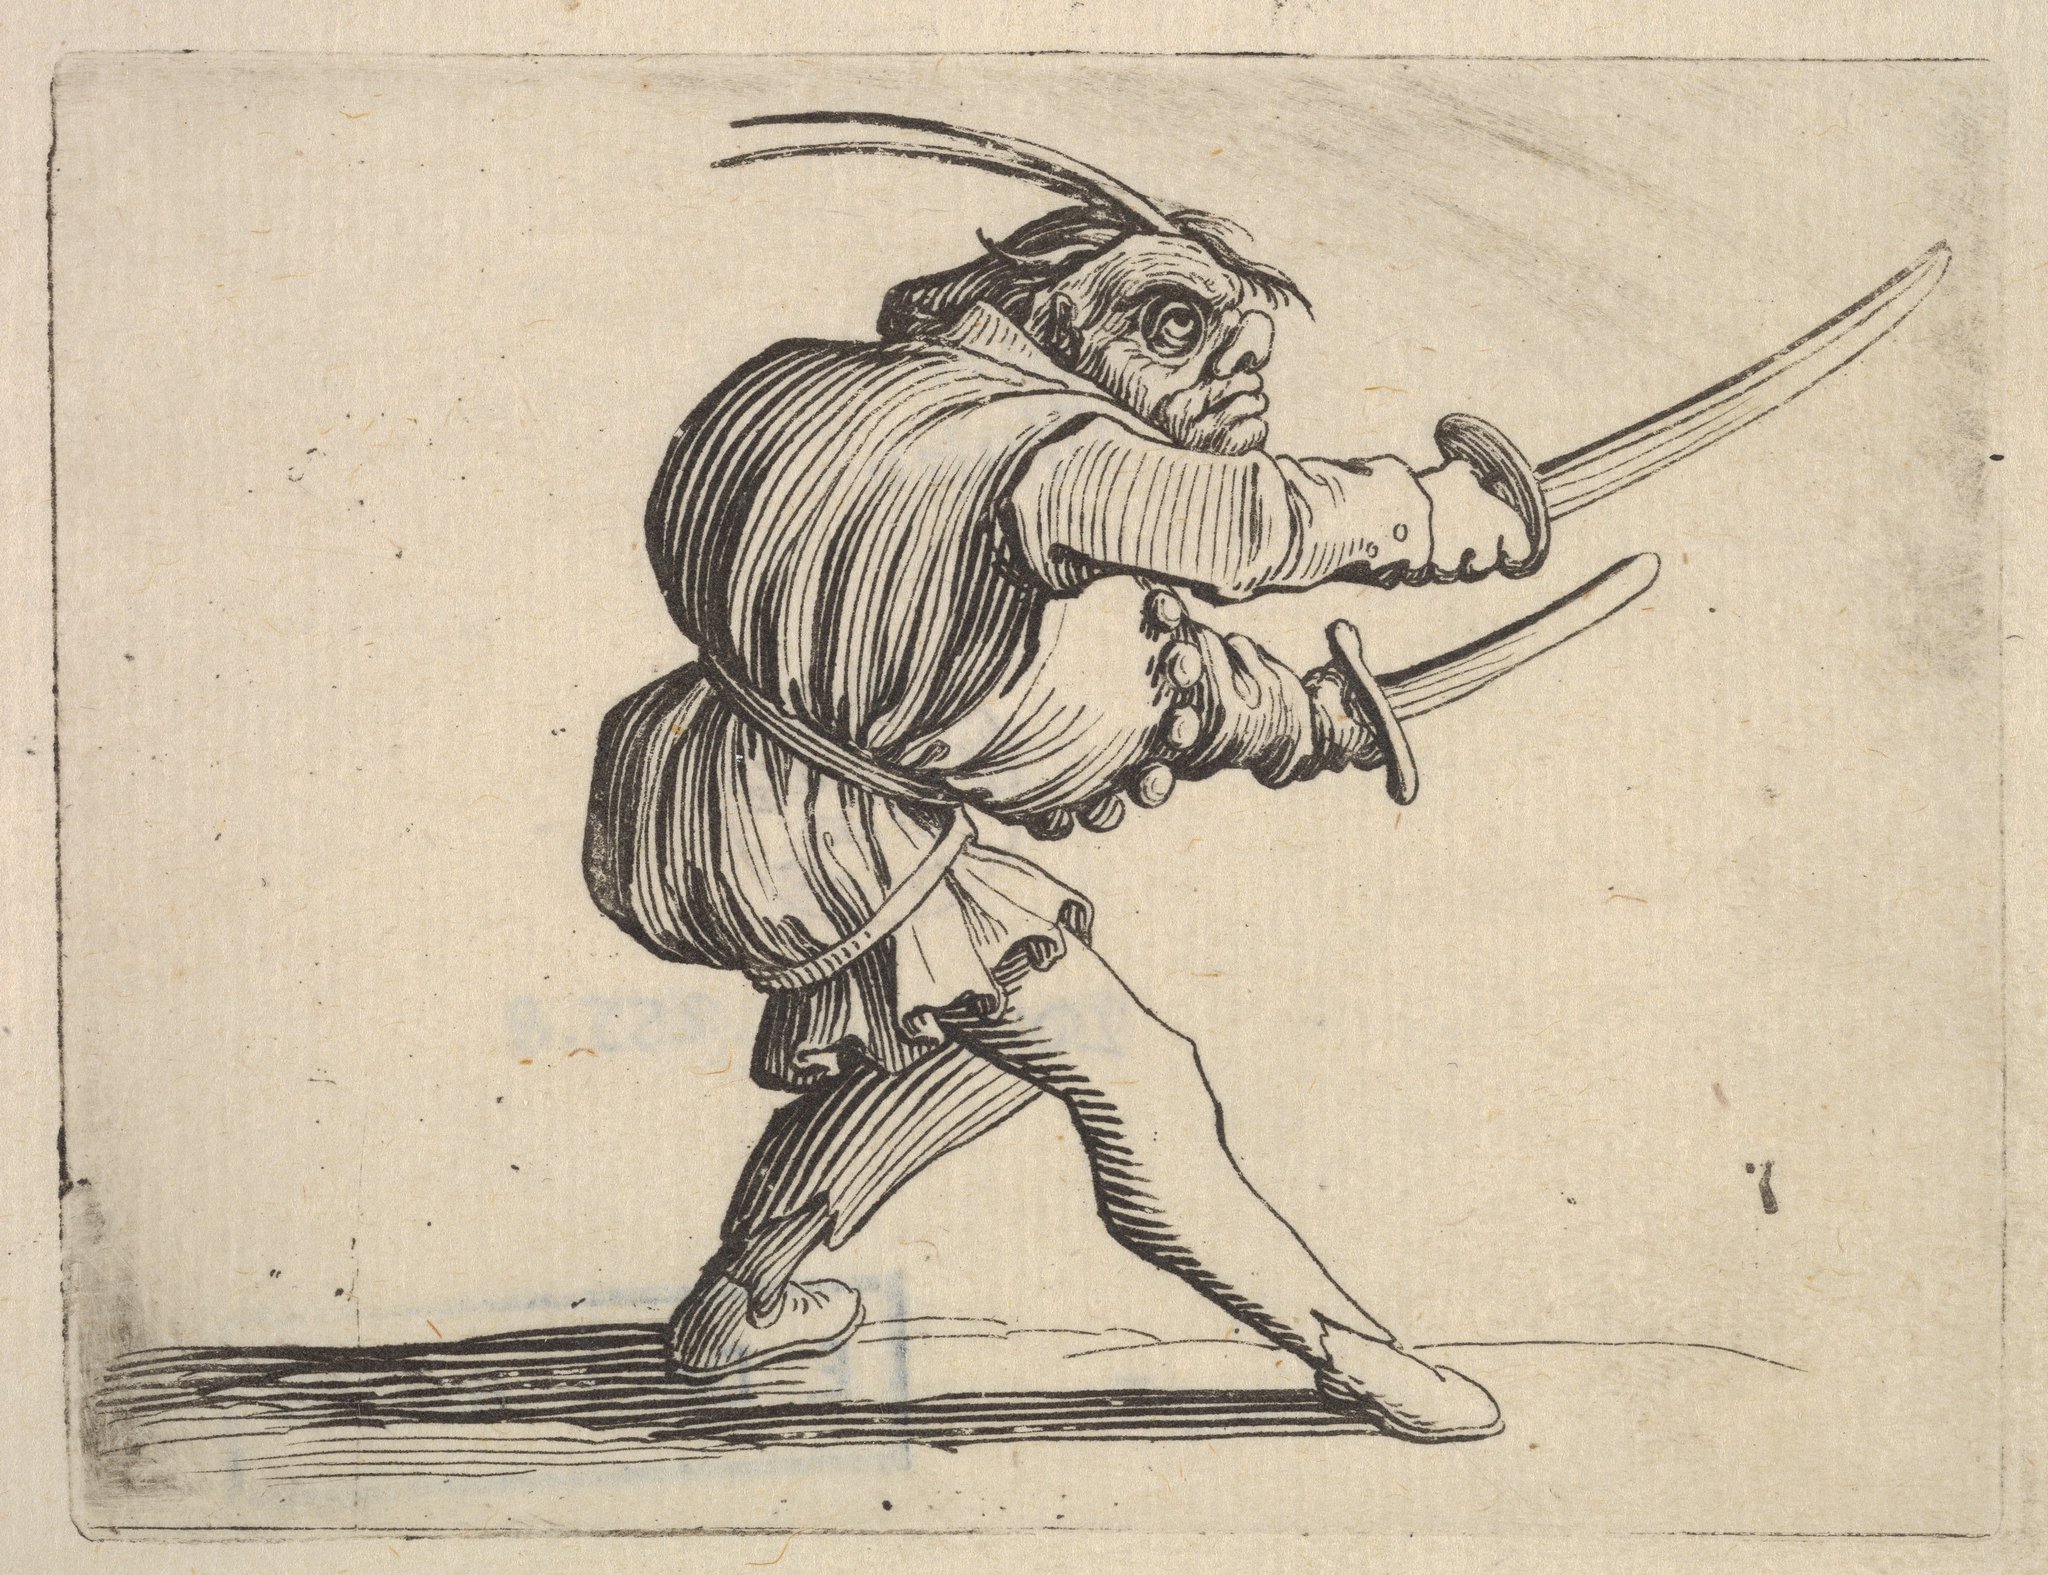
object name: print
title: Masked small figure with a sword in both hands, in profile view, striding to the right, from "Varie Figure Gobbi"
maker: jacques callot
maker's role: artist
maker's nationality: french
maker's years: 1592-1635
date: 1621-1625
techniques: etching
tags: masks,swords,men